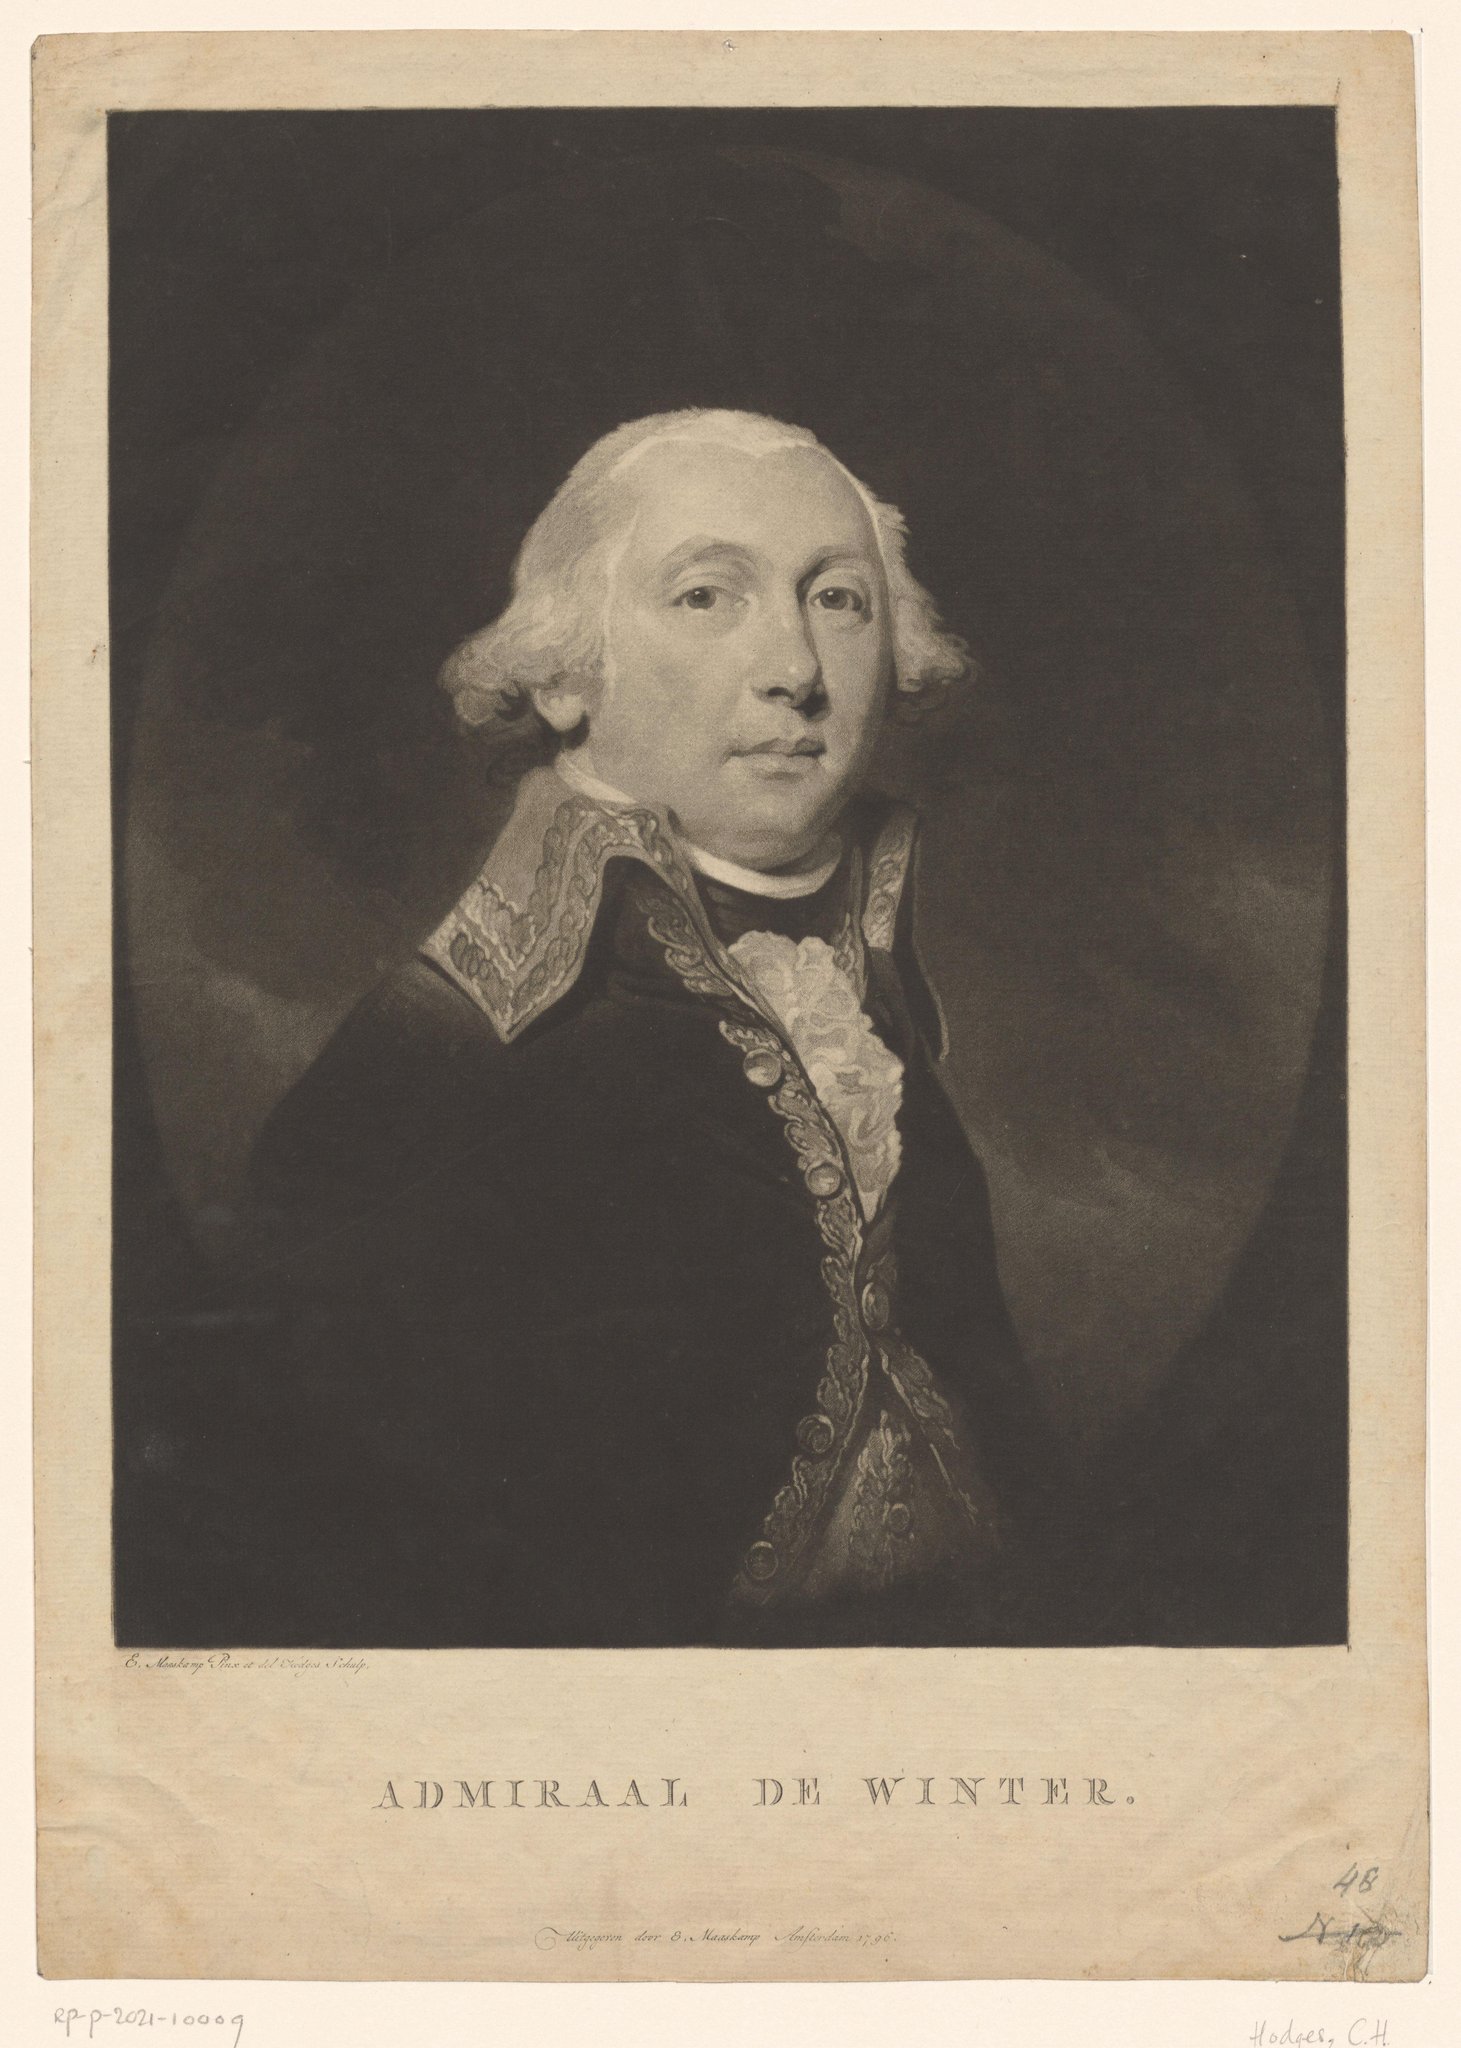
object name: print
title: Portret van Jan Willem de Winter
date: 1796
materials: paper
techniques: mezzotint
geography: amsterdam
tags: paris, jan willem de winter, historical persons, commander-in-chief, admiral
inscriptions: date